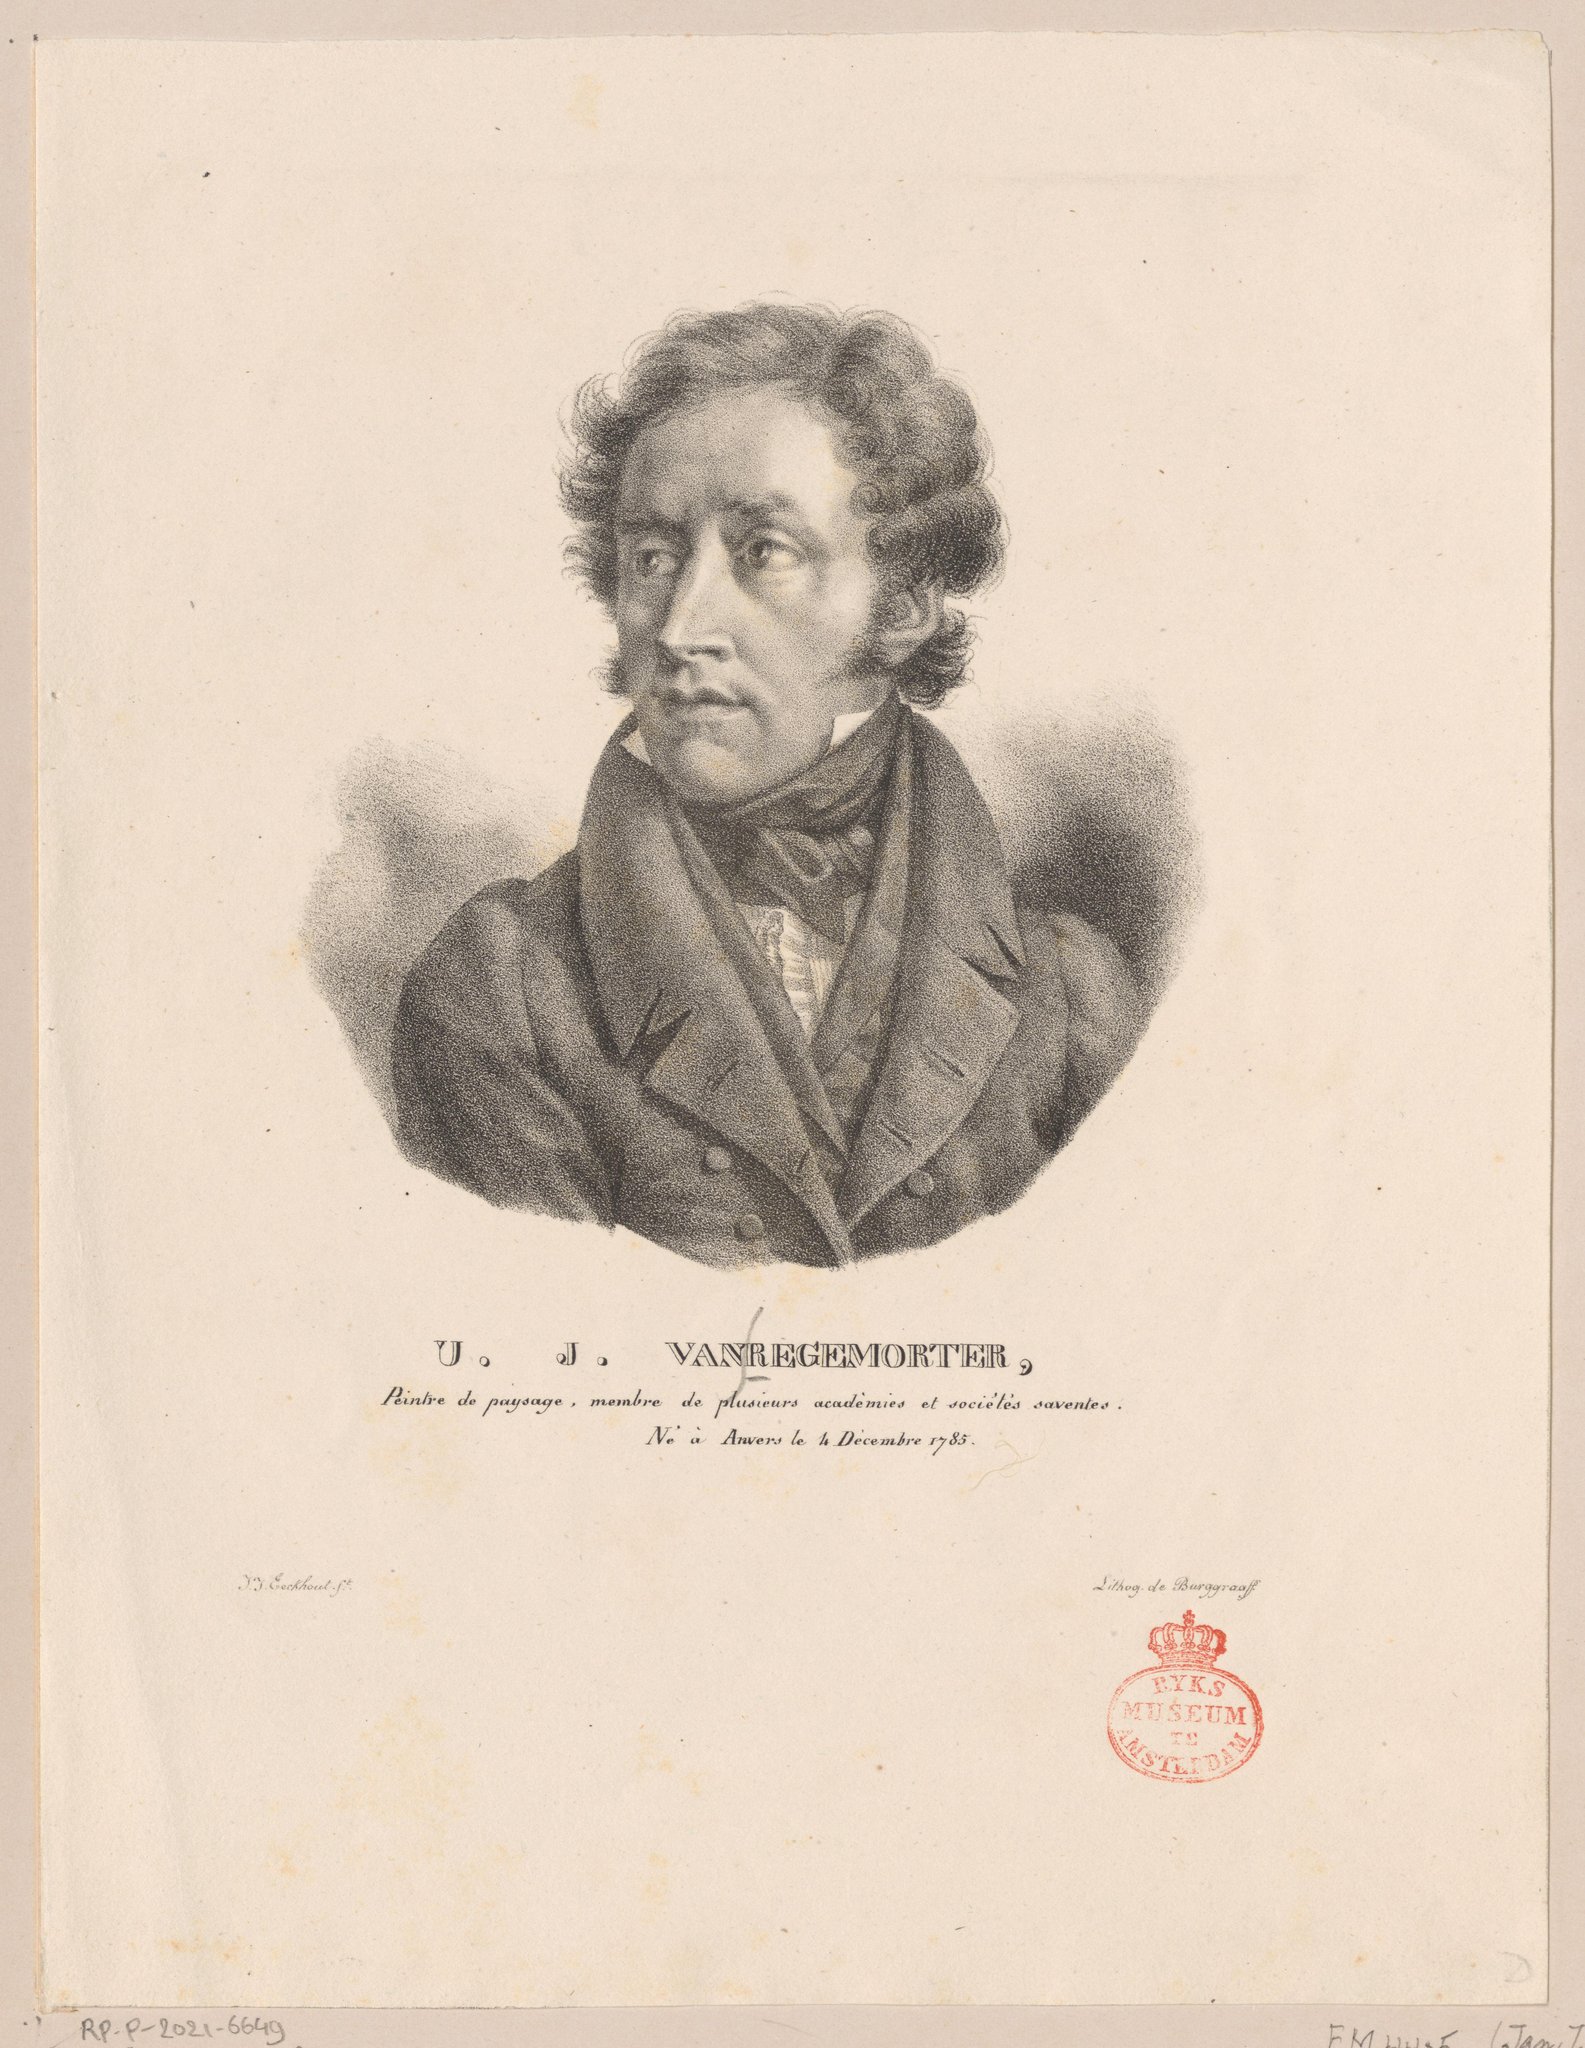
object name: print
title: Portret van Ignatius Josephus Van Regemorter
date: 1803-1850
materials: paper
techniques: lithograph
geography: brussels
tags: antwerp, painter, print maker, conservator, ignatius josephus van regemorter, historical persons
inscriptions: collector's mark: Lugt 12